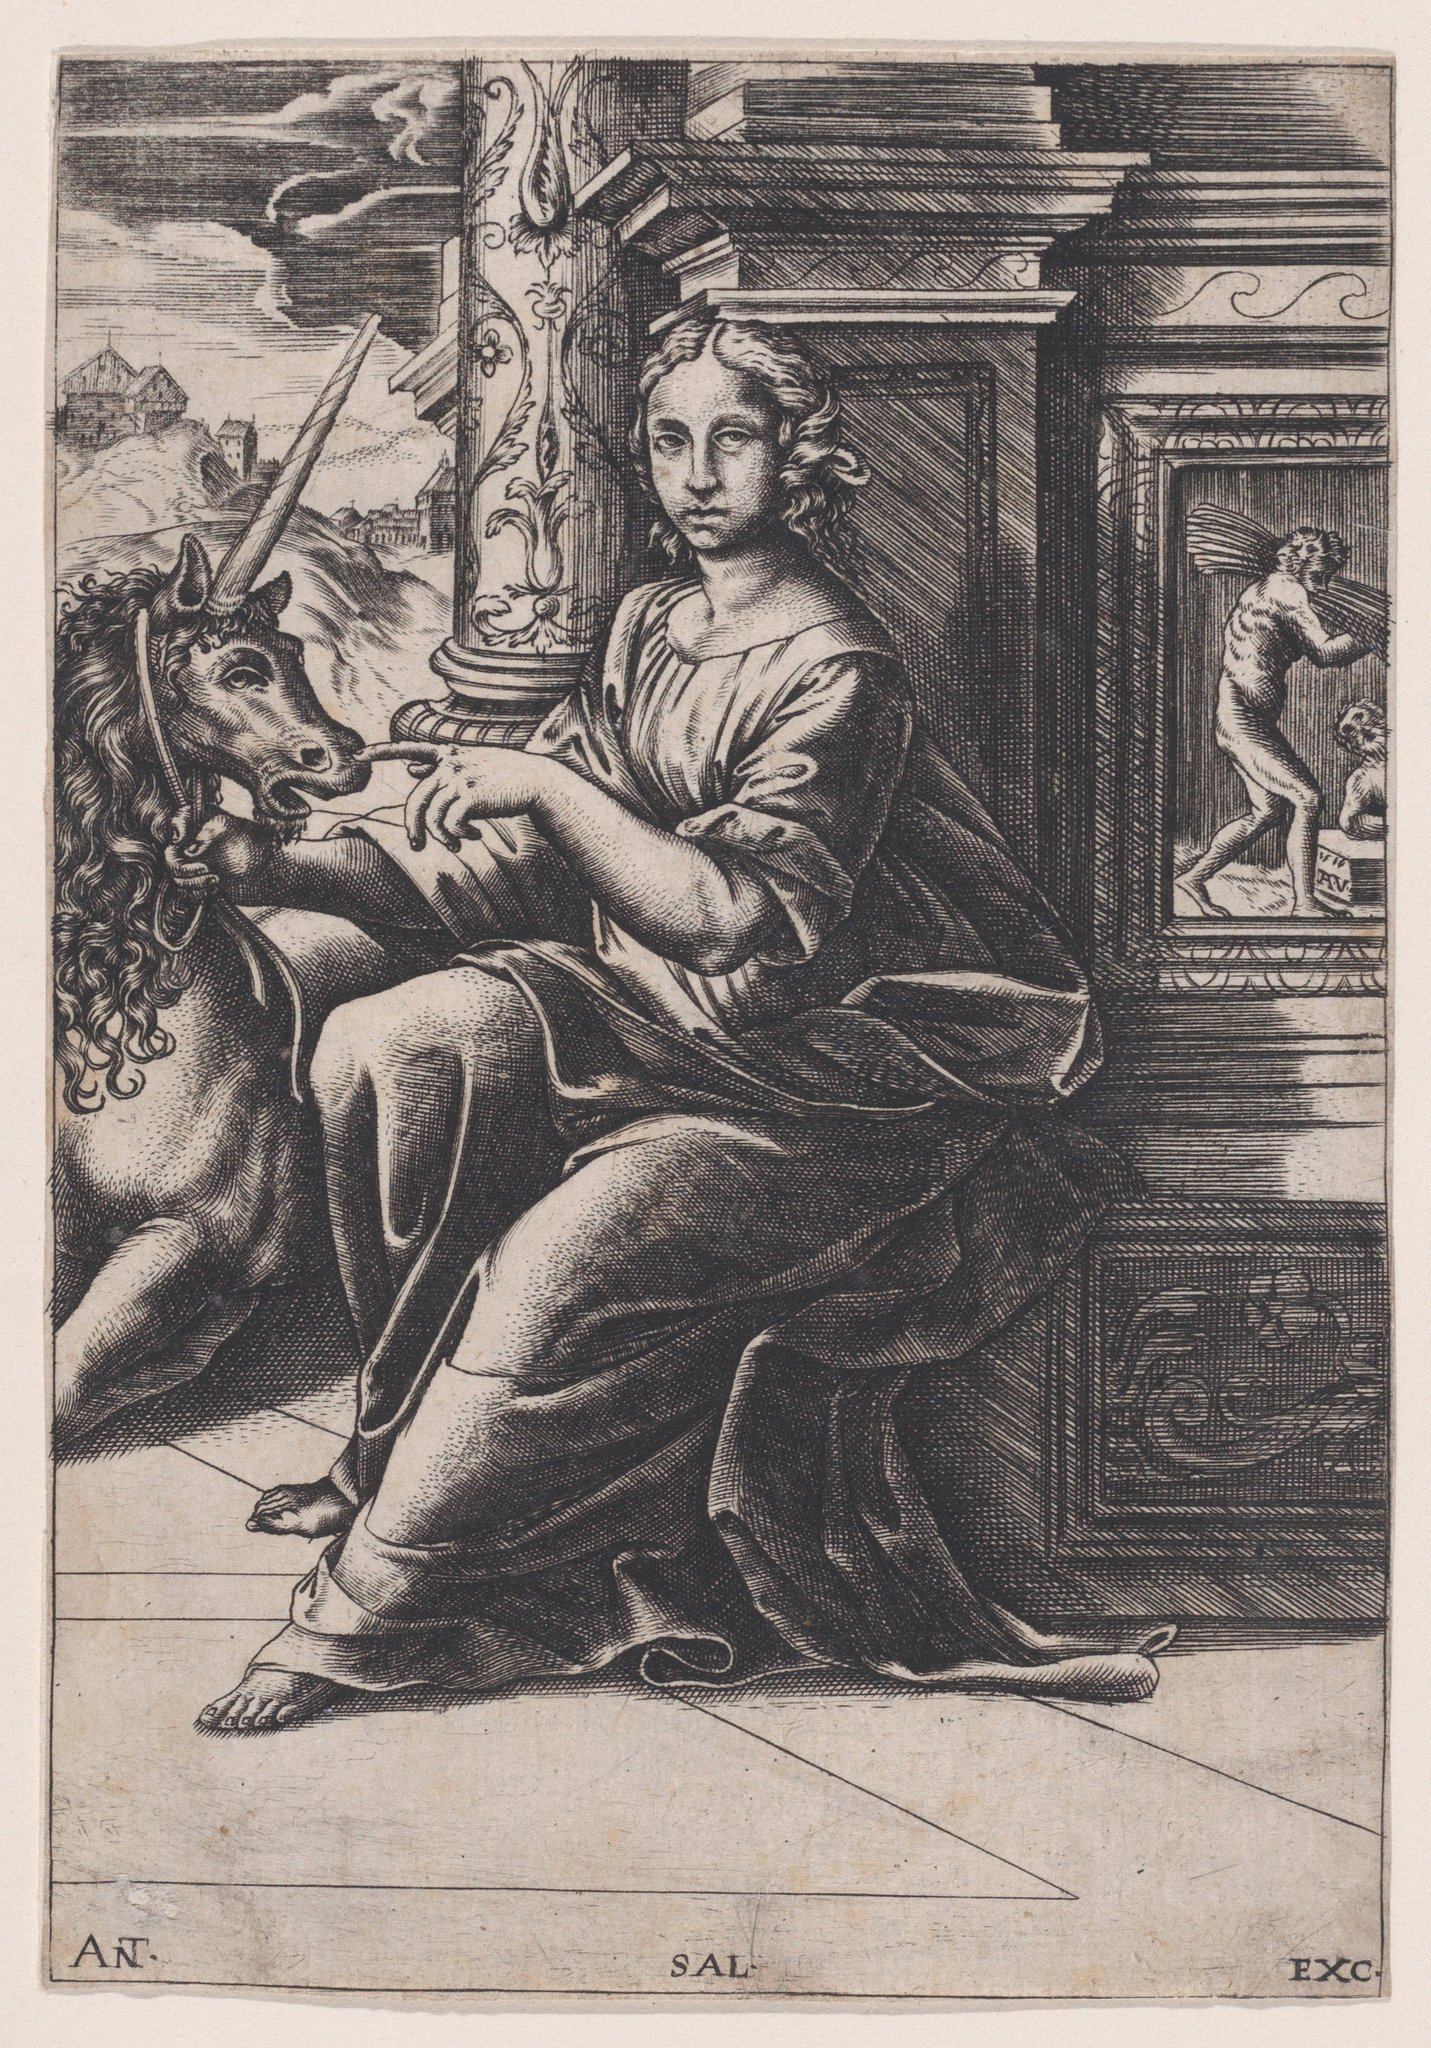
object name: print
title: Chastity, a woman seated, a unicorn to her right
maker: agostino veneziano (agostino dei musi)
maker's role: artist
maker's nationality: italian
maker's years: 1490-1536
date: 1515-1530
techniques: engraving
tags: women,allegory